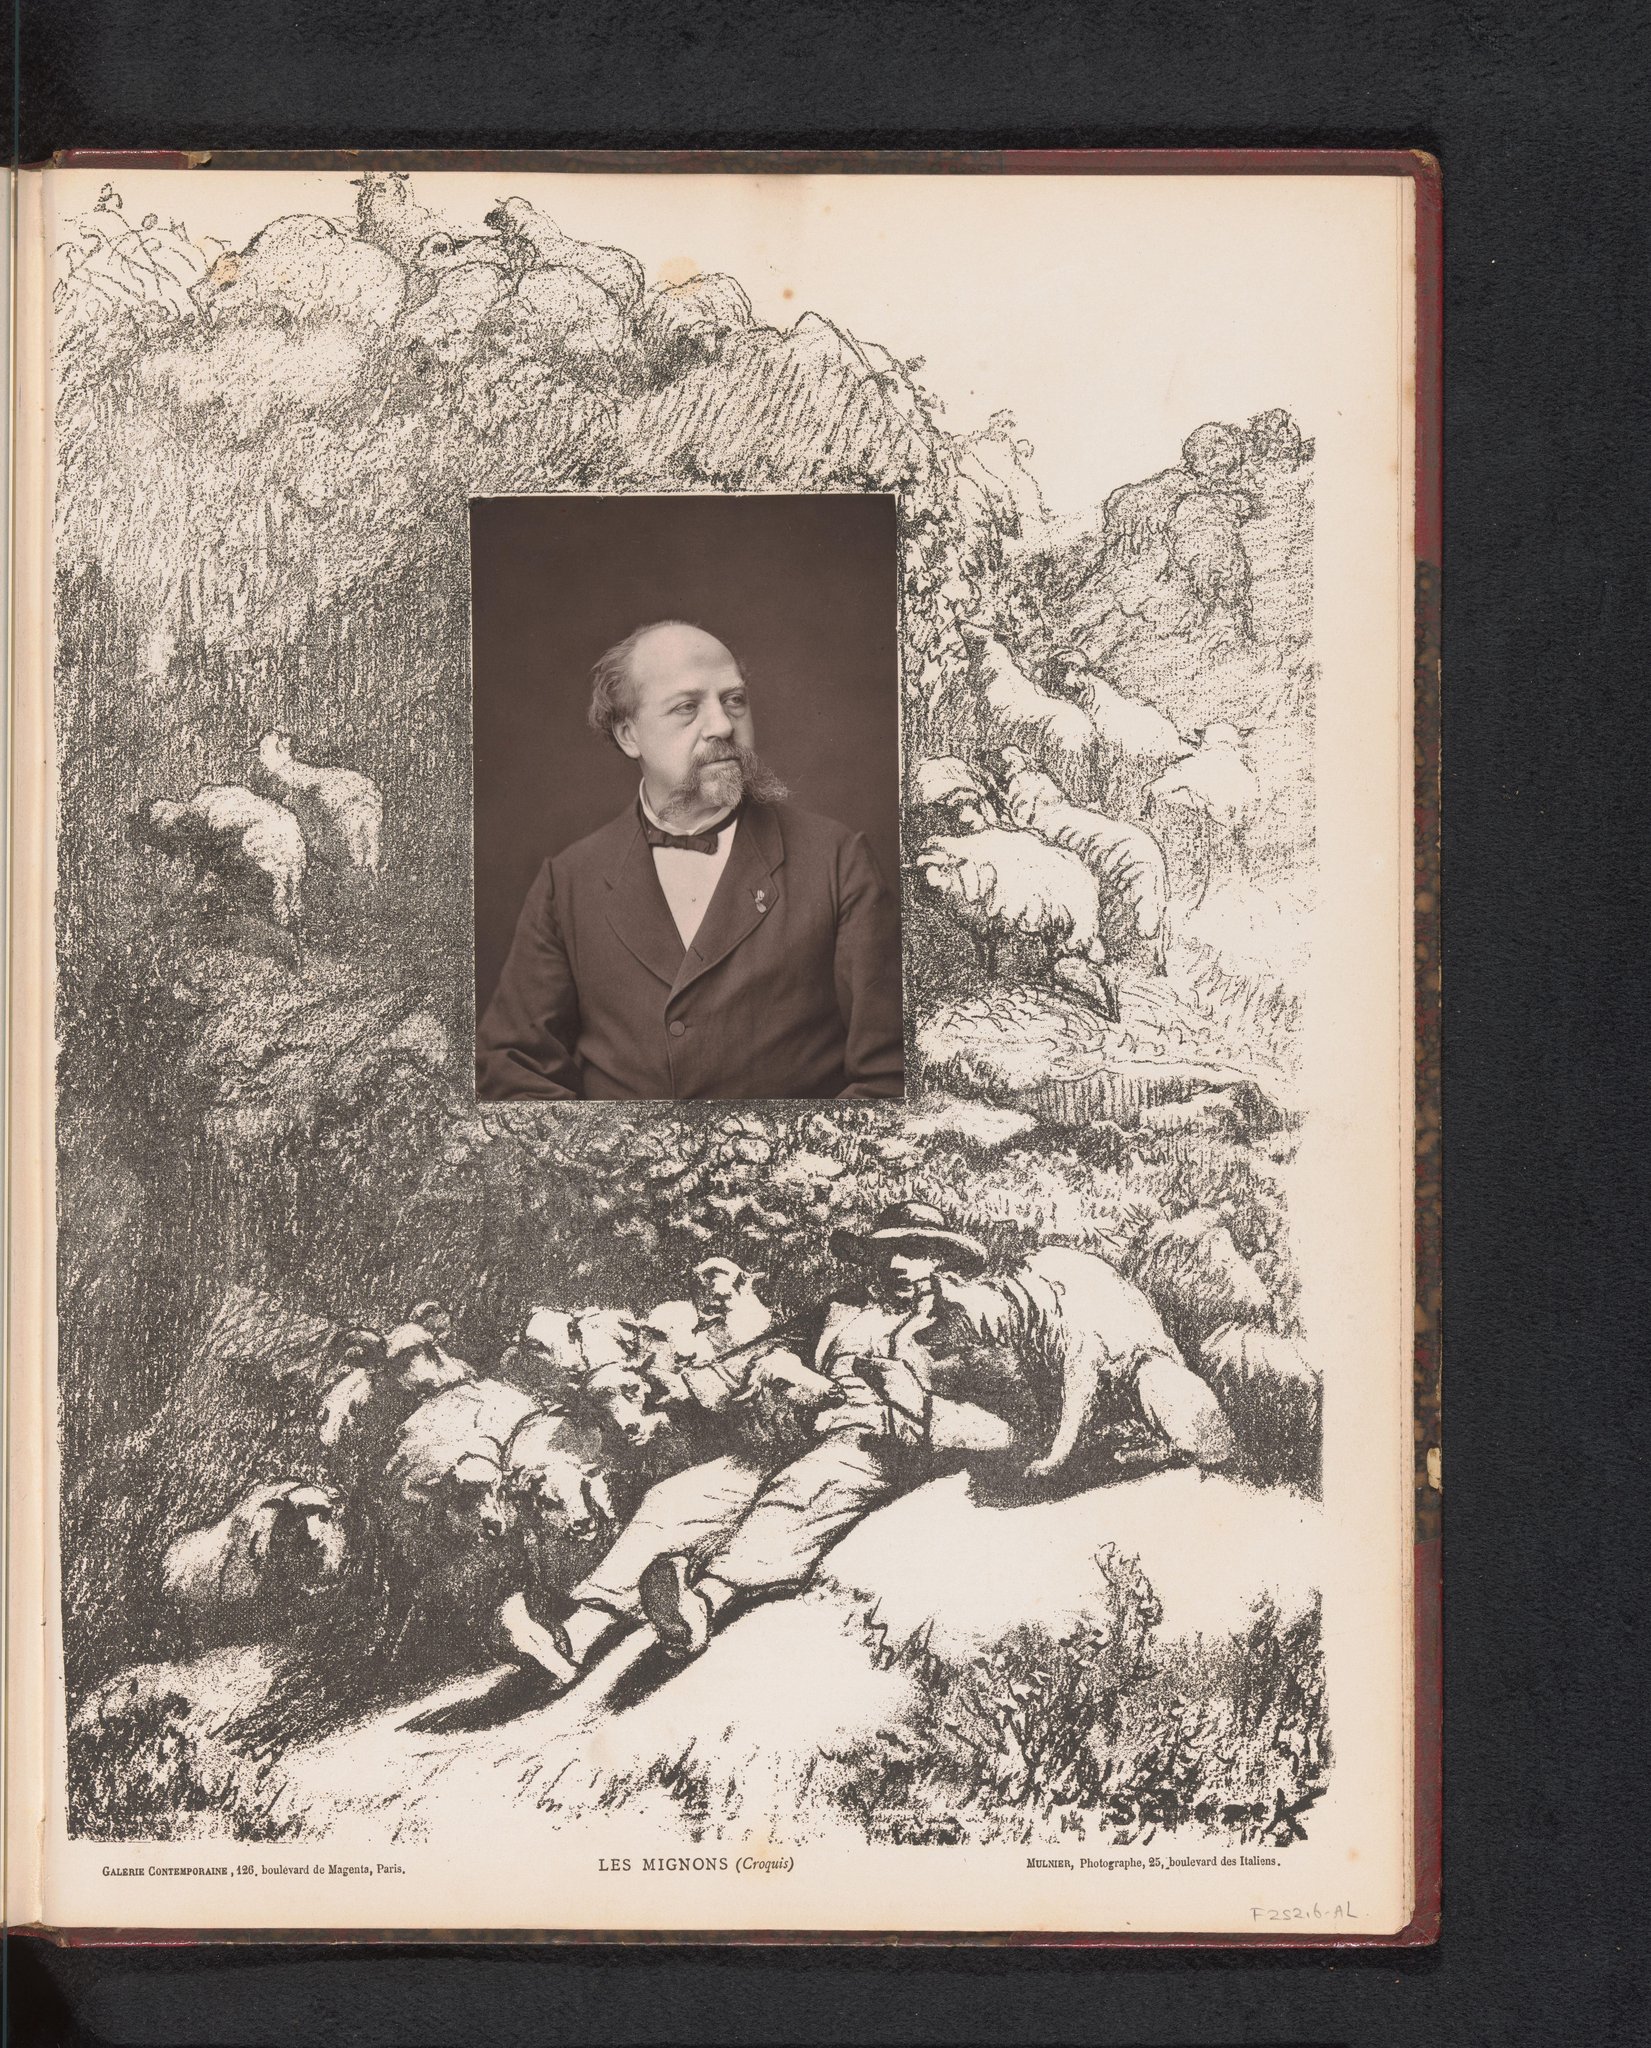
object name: page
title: Portret van August Friedrich Albrecht Schenck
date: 1867-1876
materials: paper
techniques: printing block, woodburytype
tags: painter, august friedrich albrecht schenck, adult man, historical persons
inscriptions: inscription: ‘Galerie Contemporaine, 126, boulevard de Magenta, Paris.’